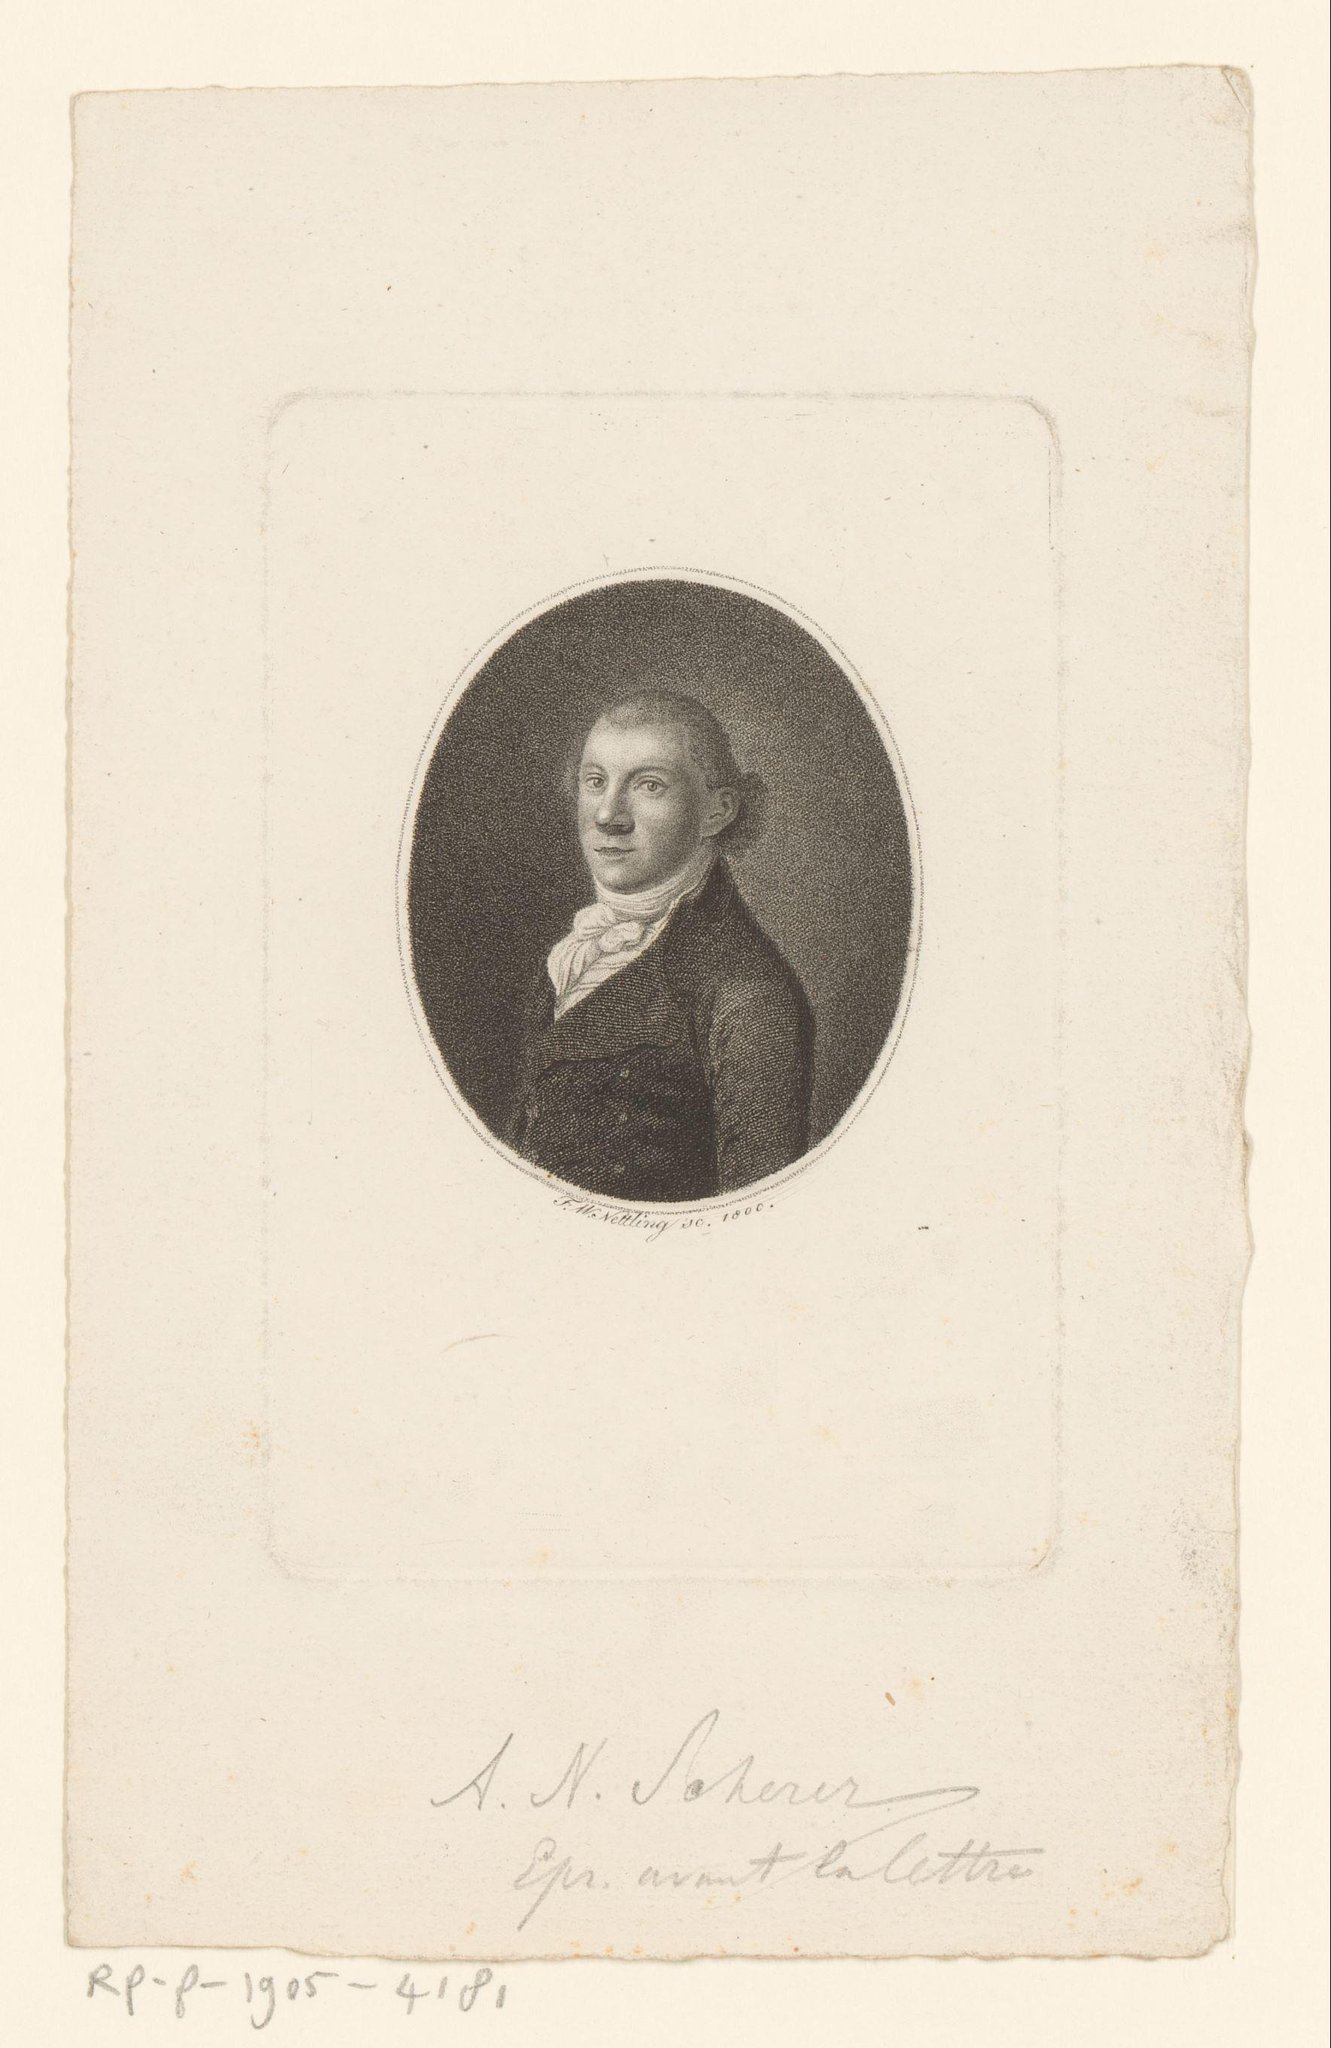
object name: print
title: Portret van Alexander Nicolaus Scherer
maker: friedrich wilhelm nettling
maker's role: print maker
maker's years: 1793-1824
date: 1800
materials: paper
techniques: engraving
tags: physicist, historical persons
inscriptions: collector's mark: Lugt 2228